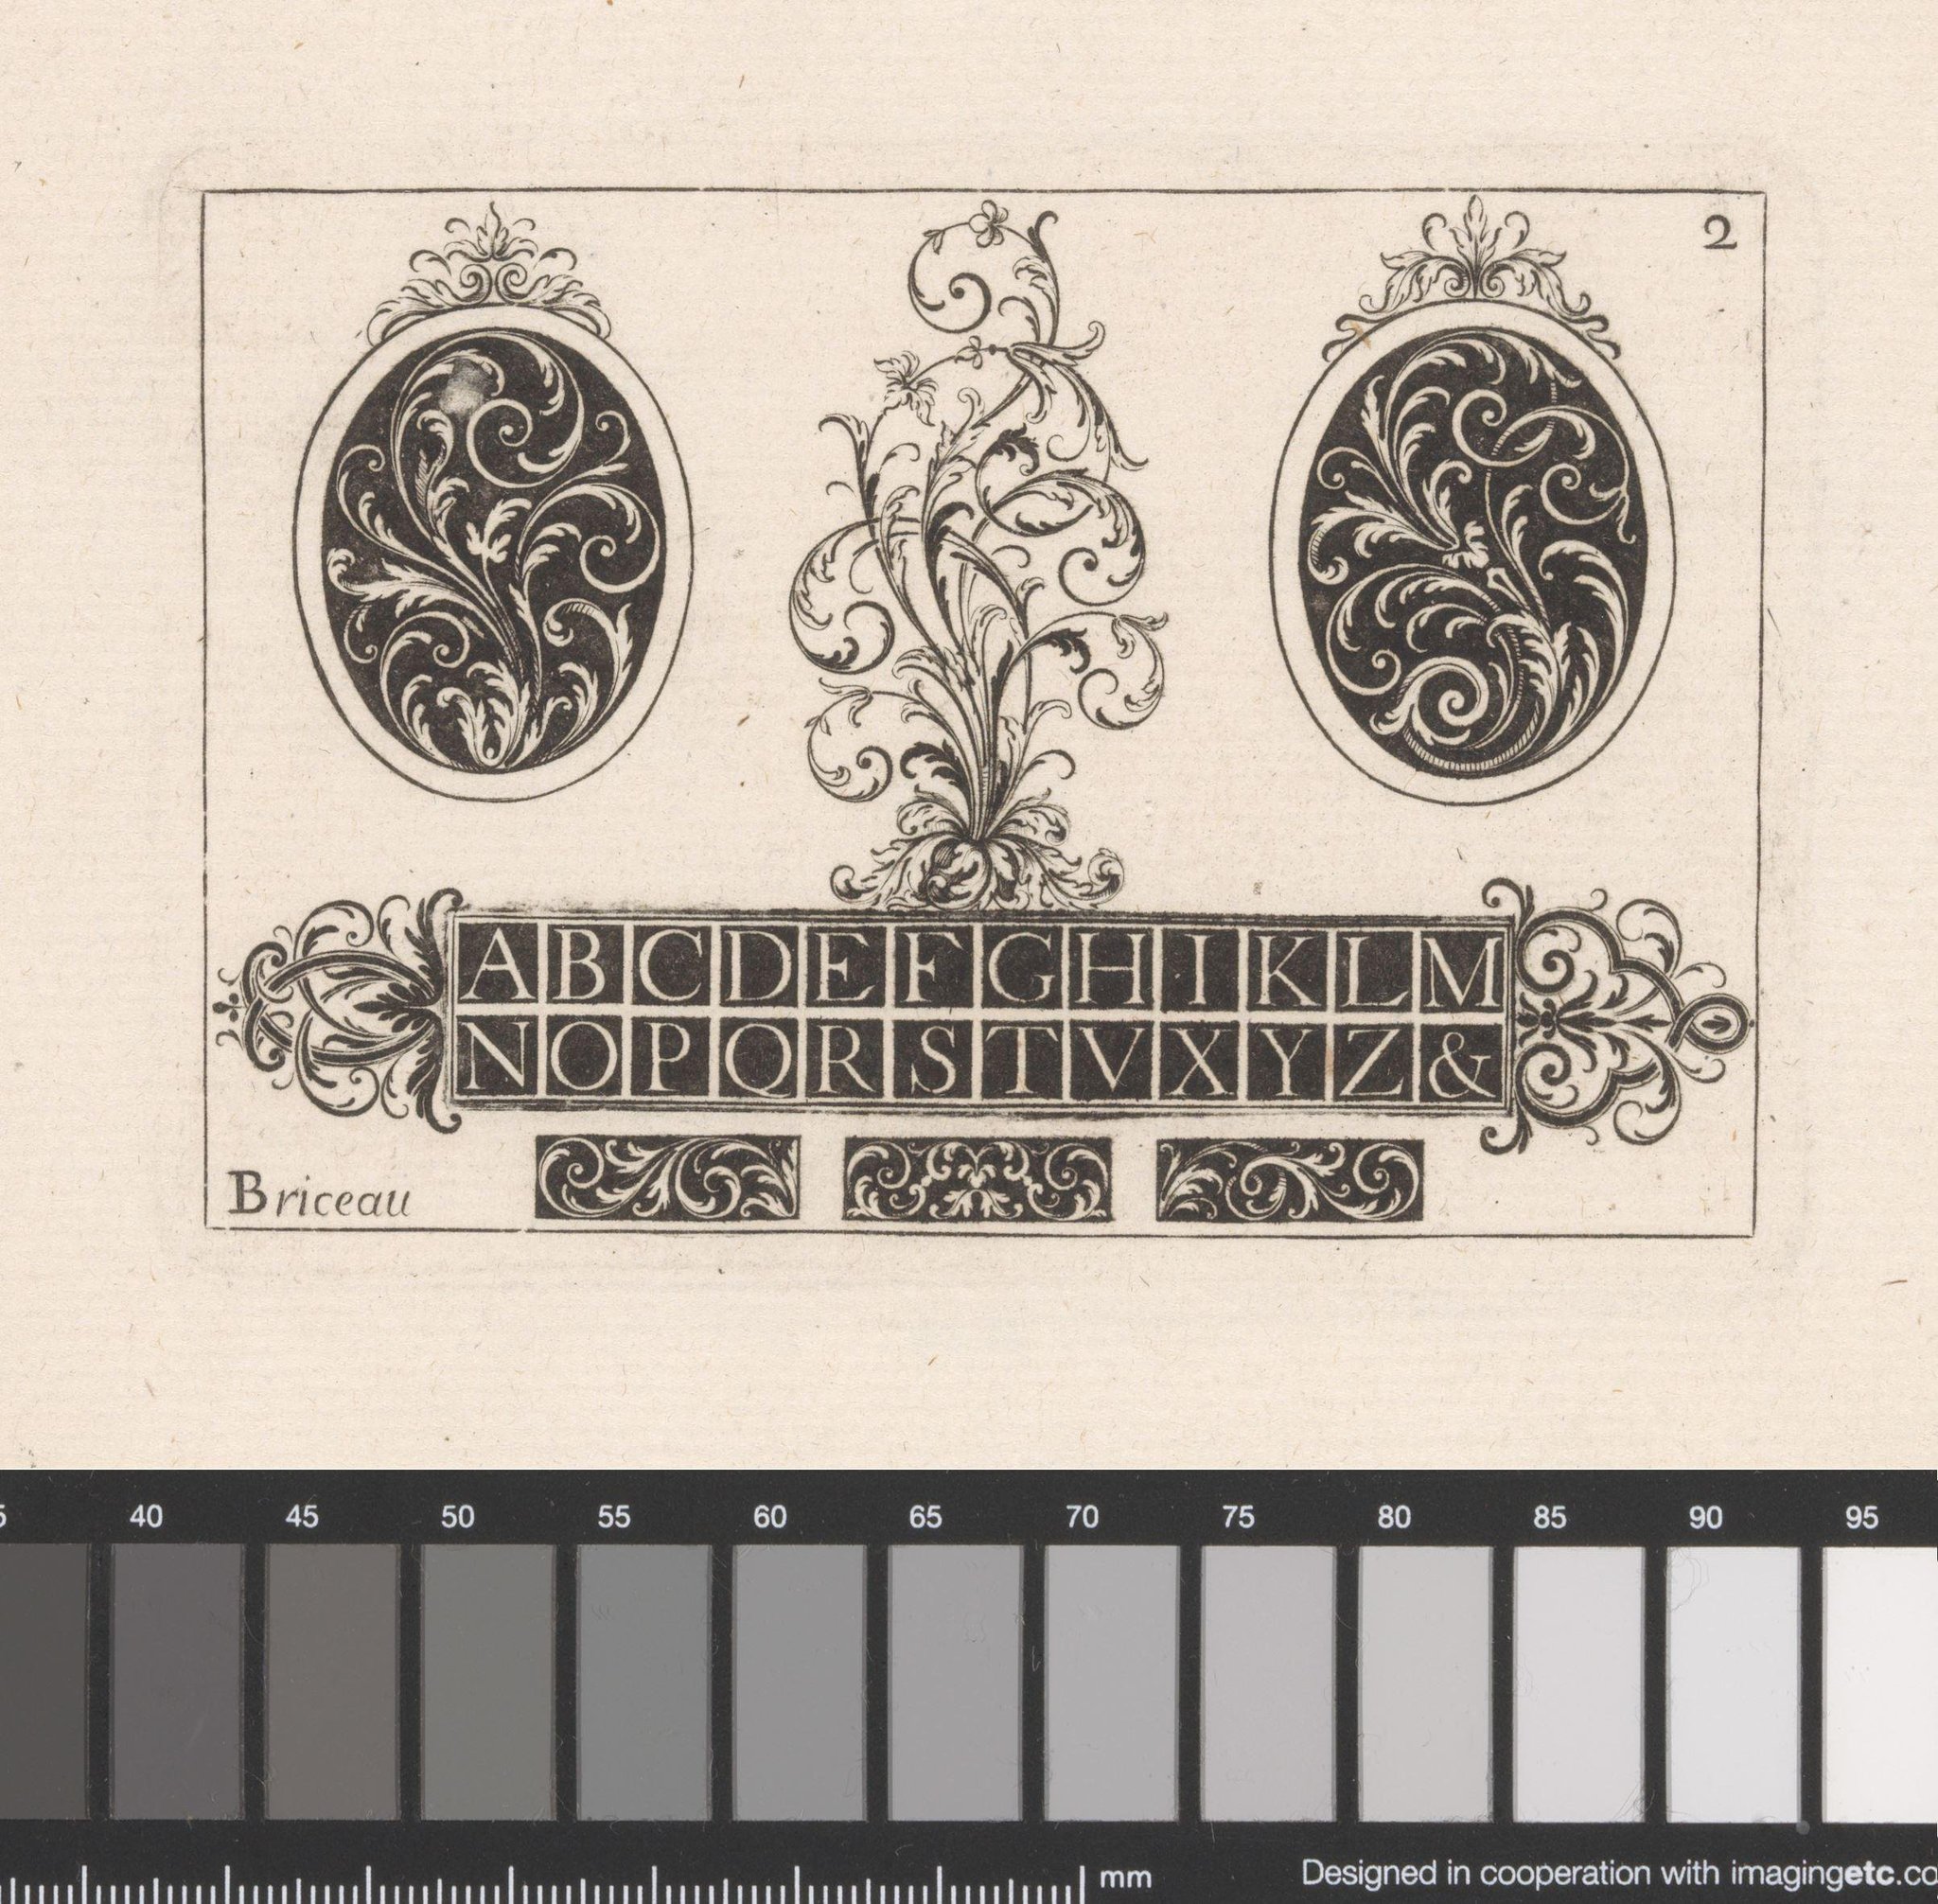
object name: ornament print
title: Nouveau Livre de Serureries (...)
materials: paper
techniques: etching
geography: paris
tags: ornament ~ medallion, roman script; scripts based on the roman alphabet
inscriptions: collector's mark: Lugt 2166, collector's mark: Lugt 2228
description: Twee ovale medaillons met vlechtwerk. Daaronder het alfabet in kapitalen.